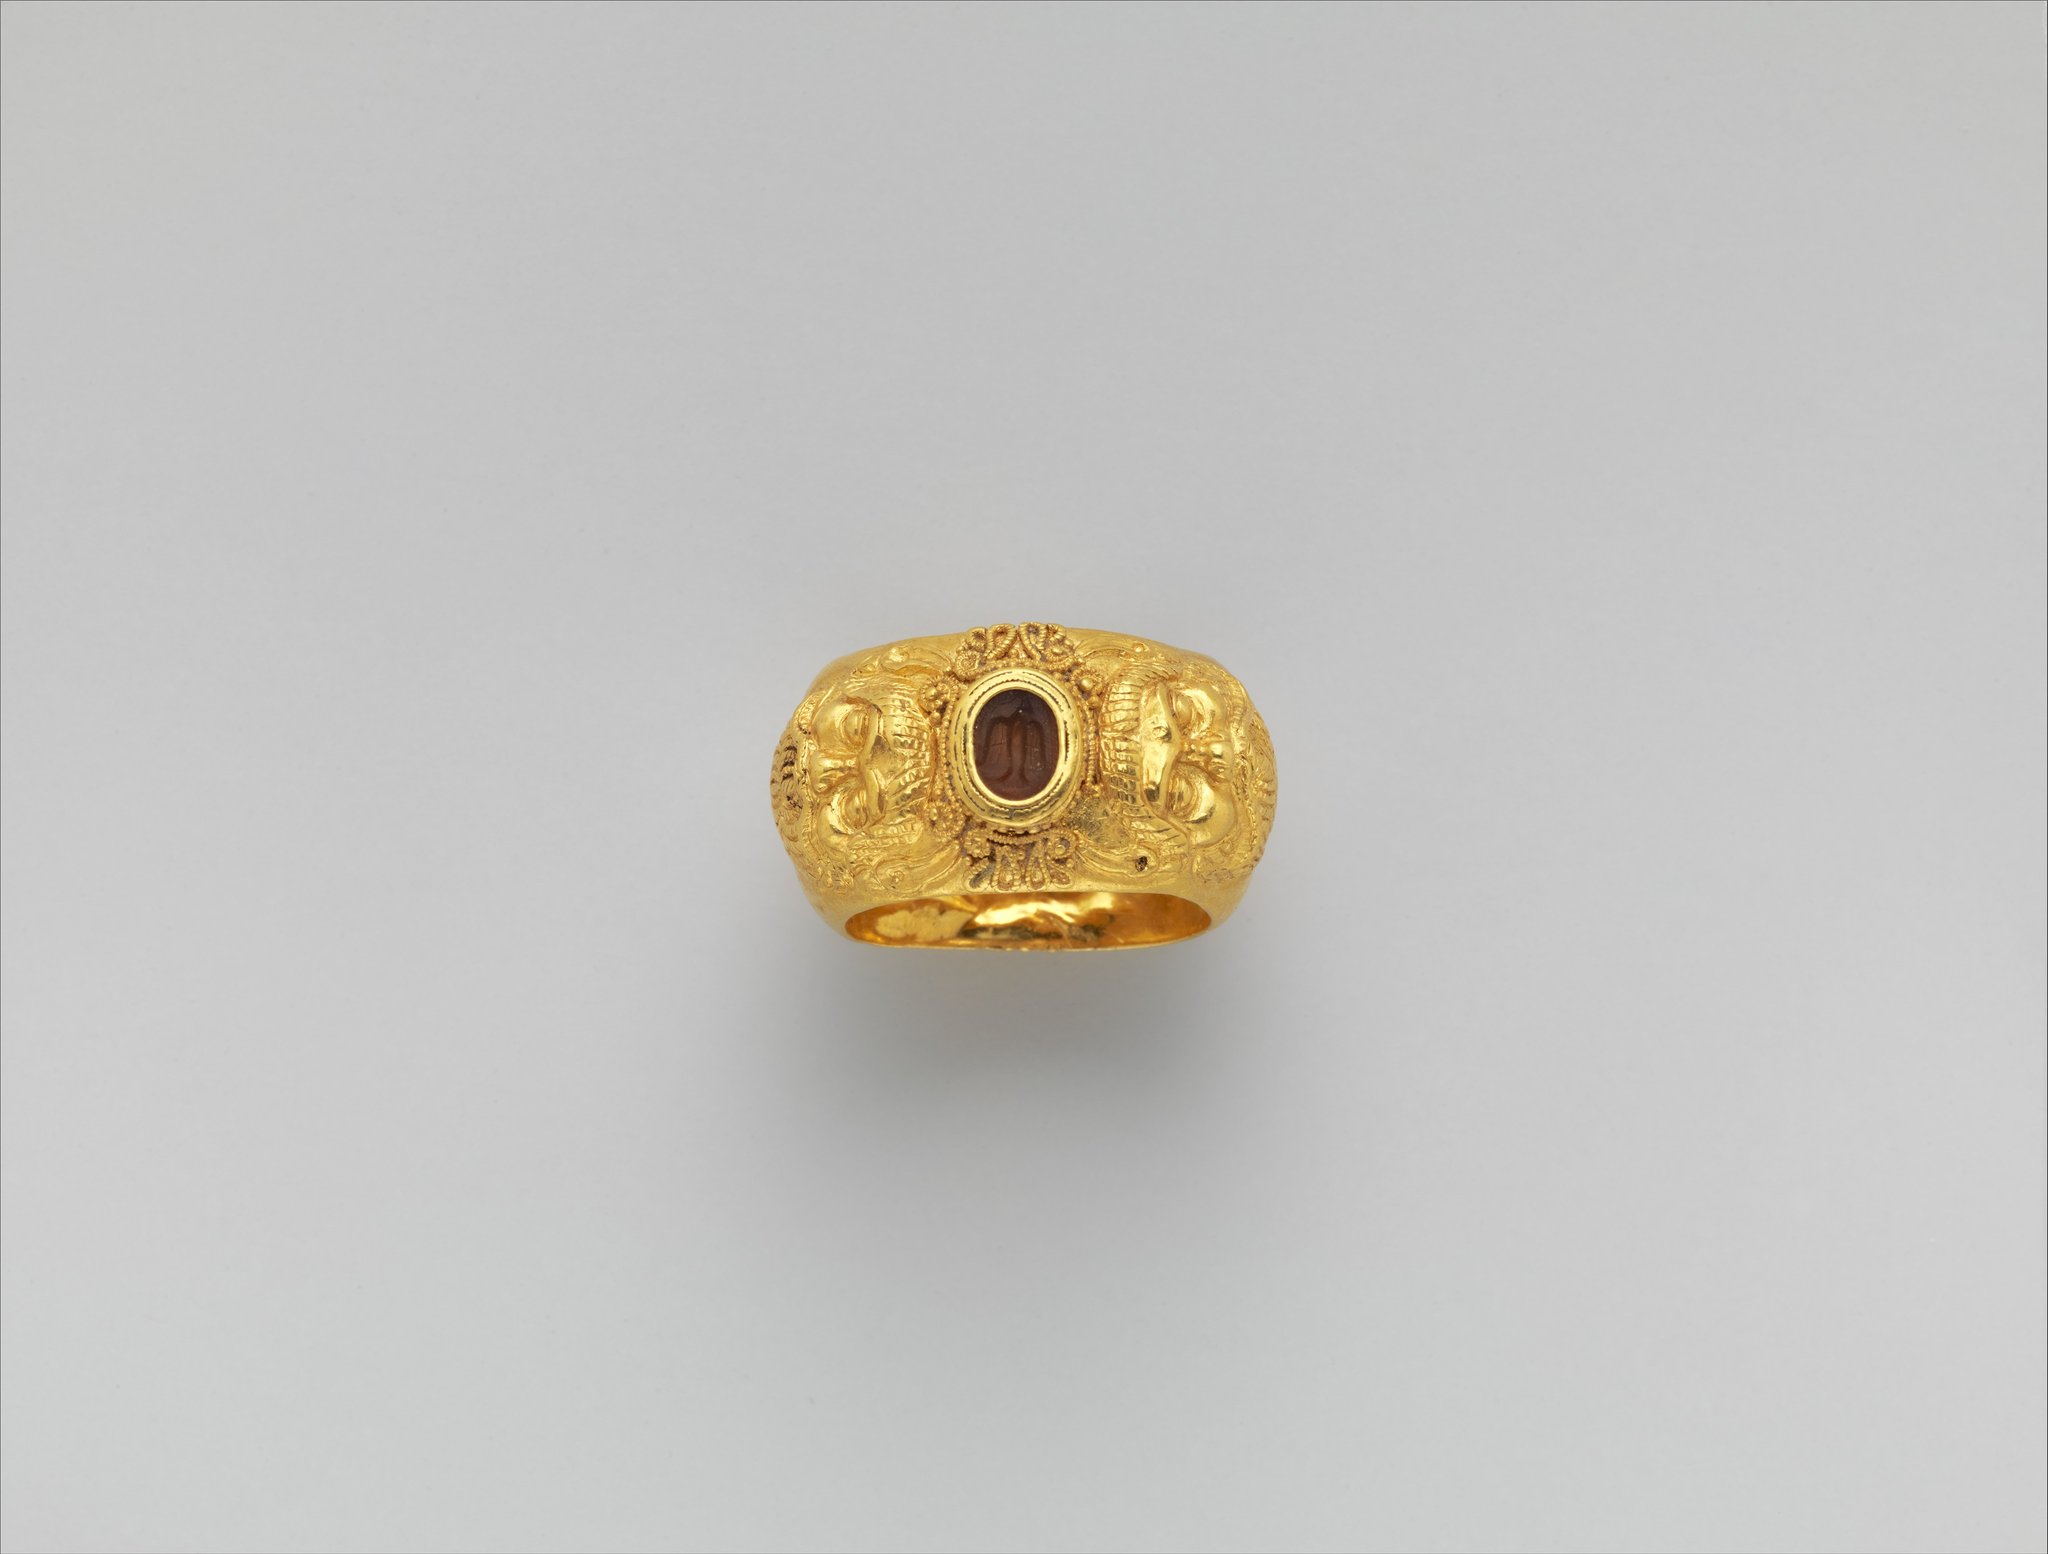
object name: ring with satyr and bird intaglio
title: Gold ring with embossed satyr masks: on carnelian intaglio, bird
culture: etruscan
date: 500-468 BCE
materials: gemstone, gold